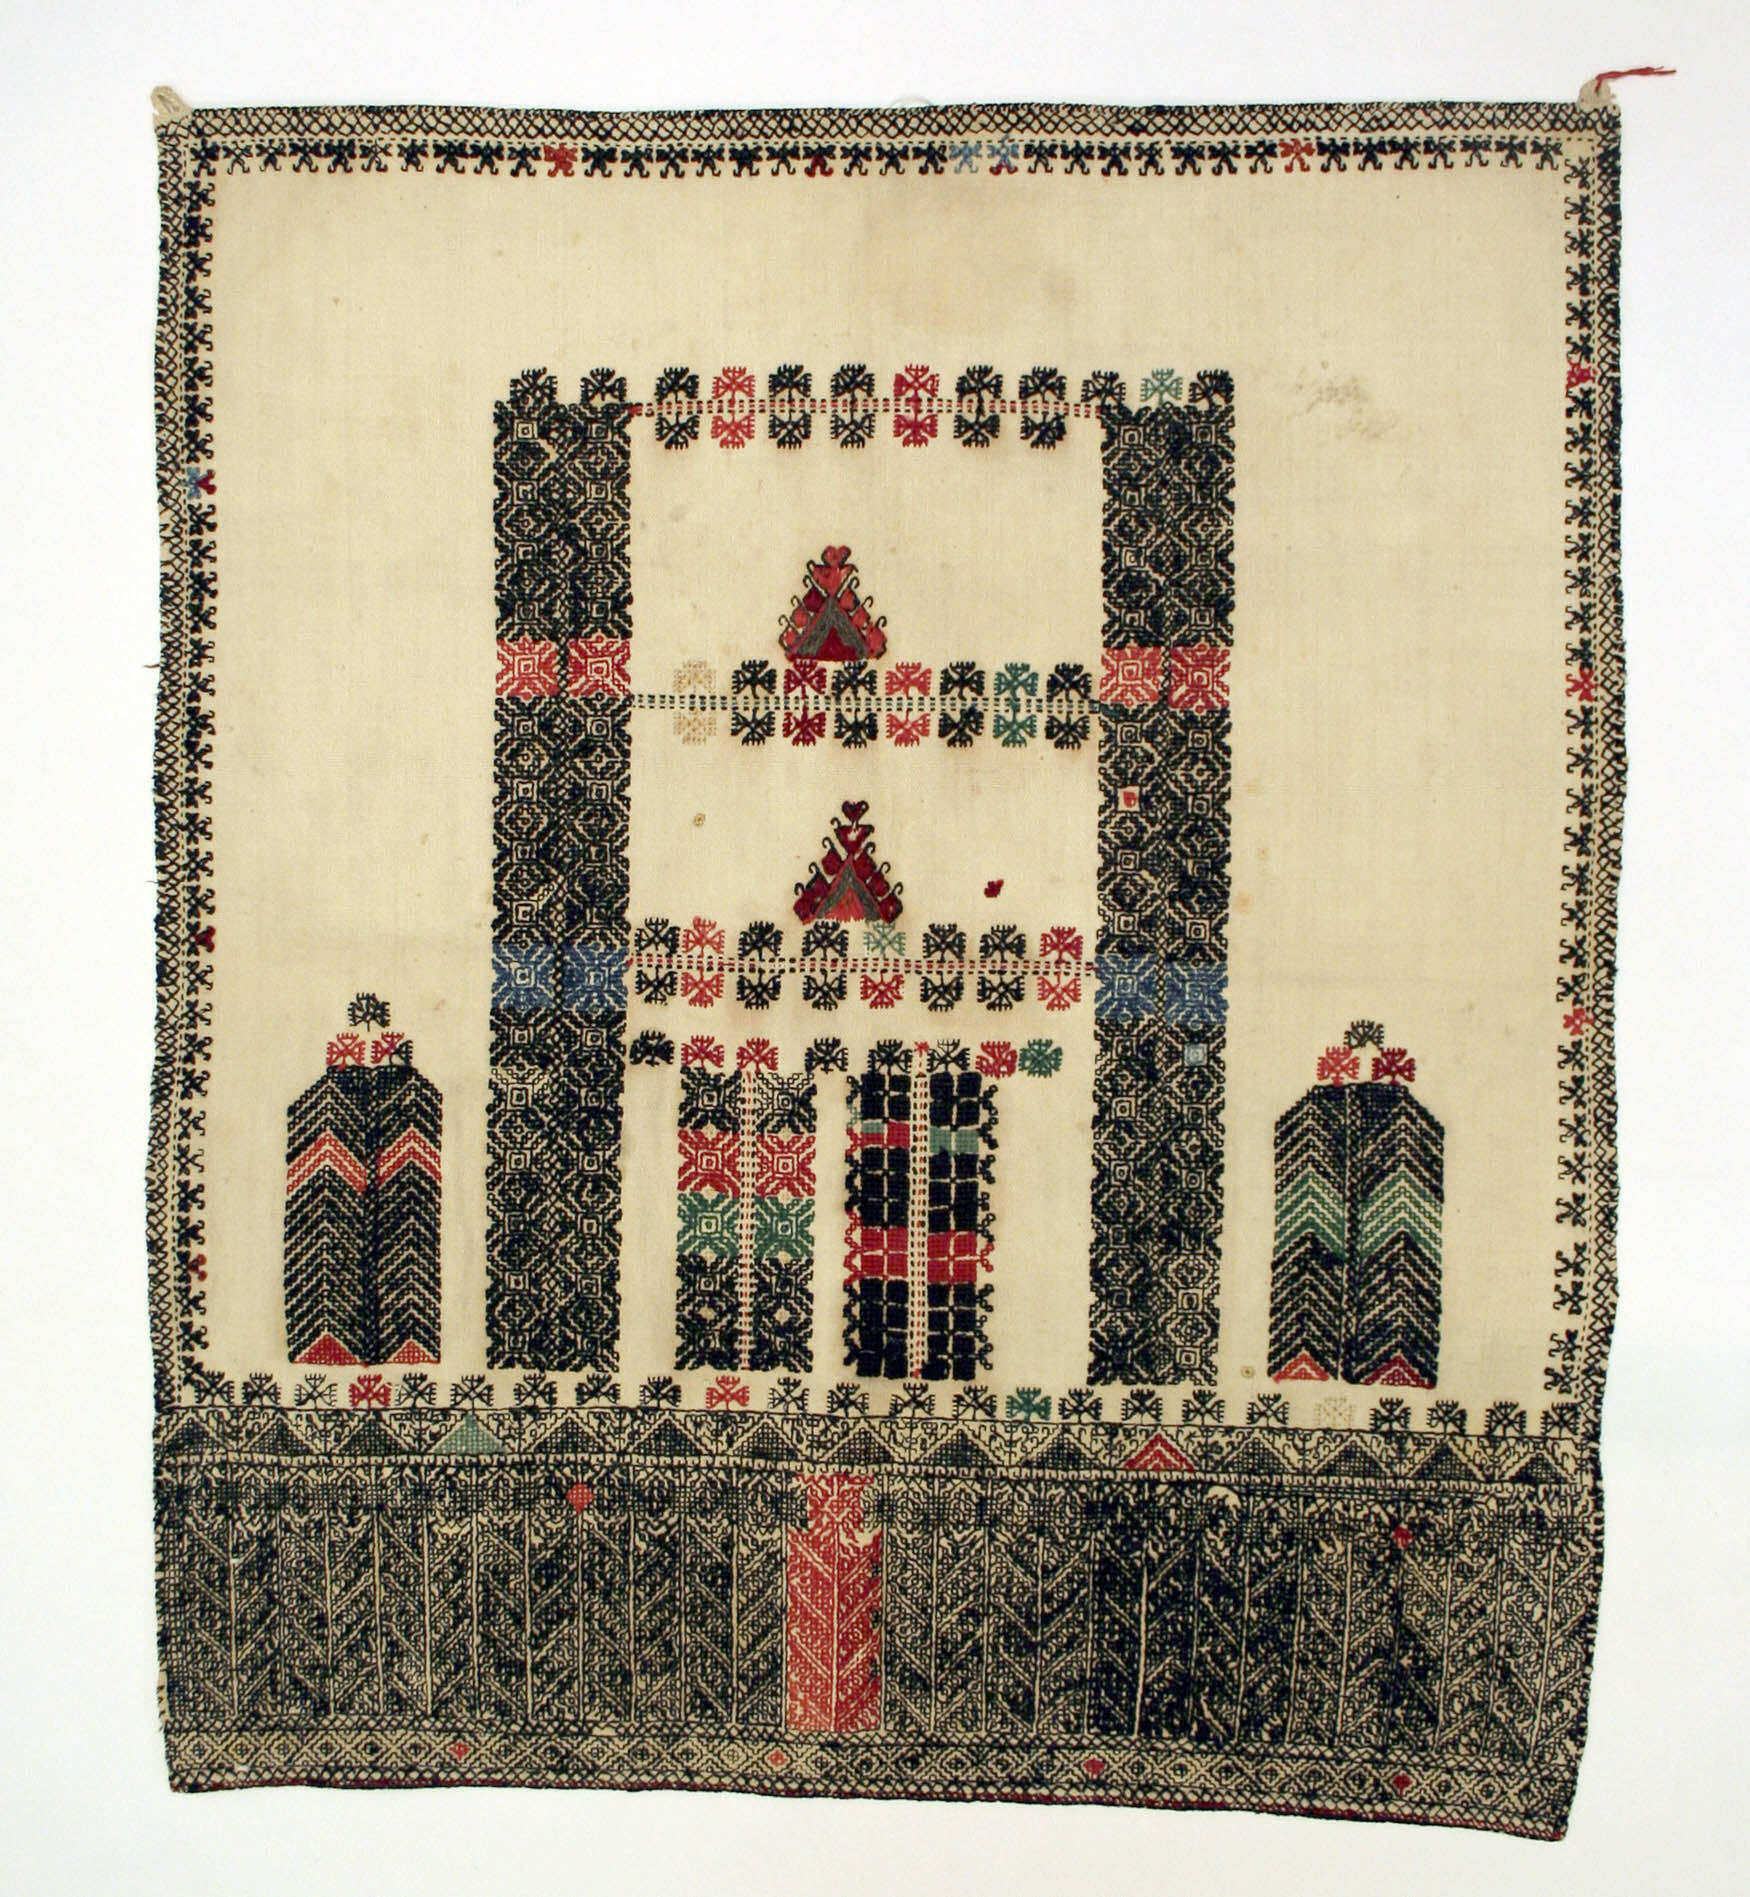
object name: apron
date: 1801-1900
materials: cotton